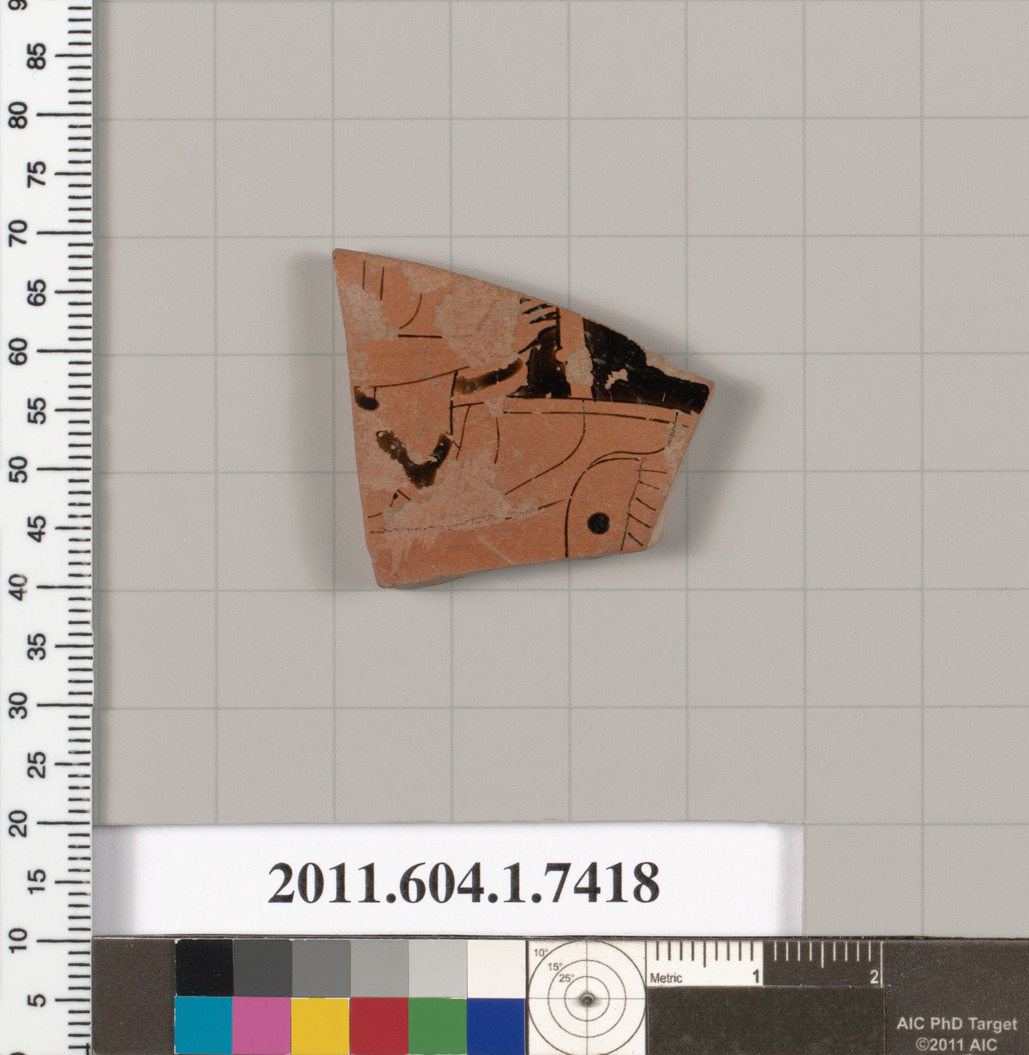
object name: kylix fragment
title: Terracotta fragment of a kylix (drinking cup)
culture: greek, attic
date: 490-470 BCE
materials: terracotta